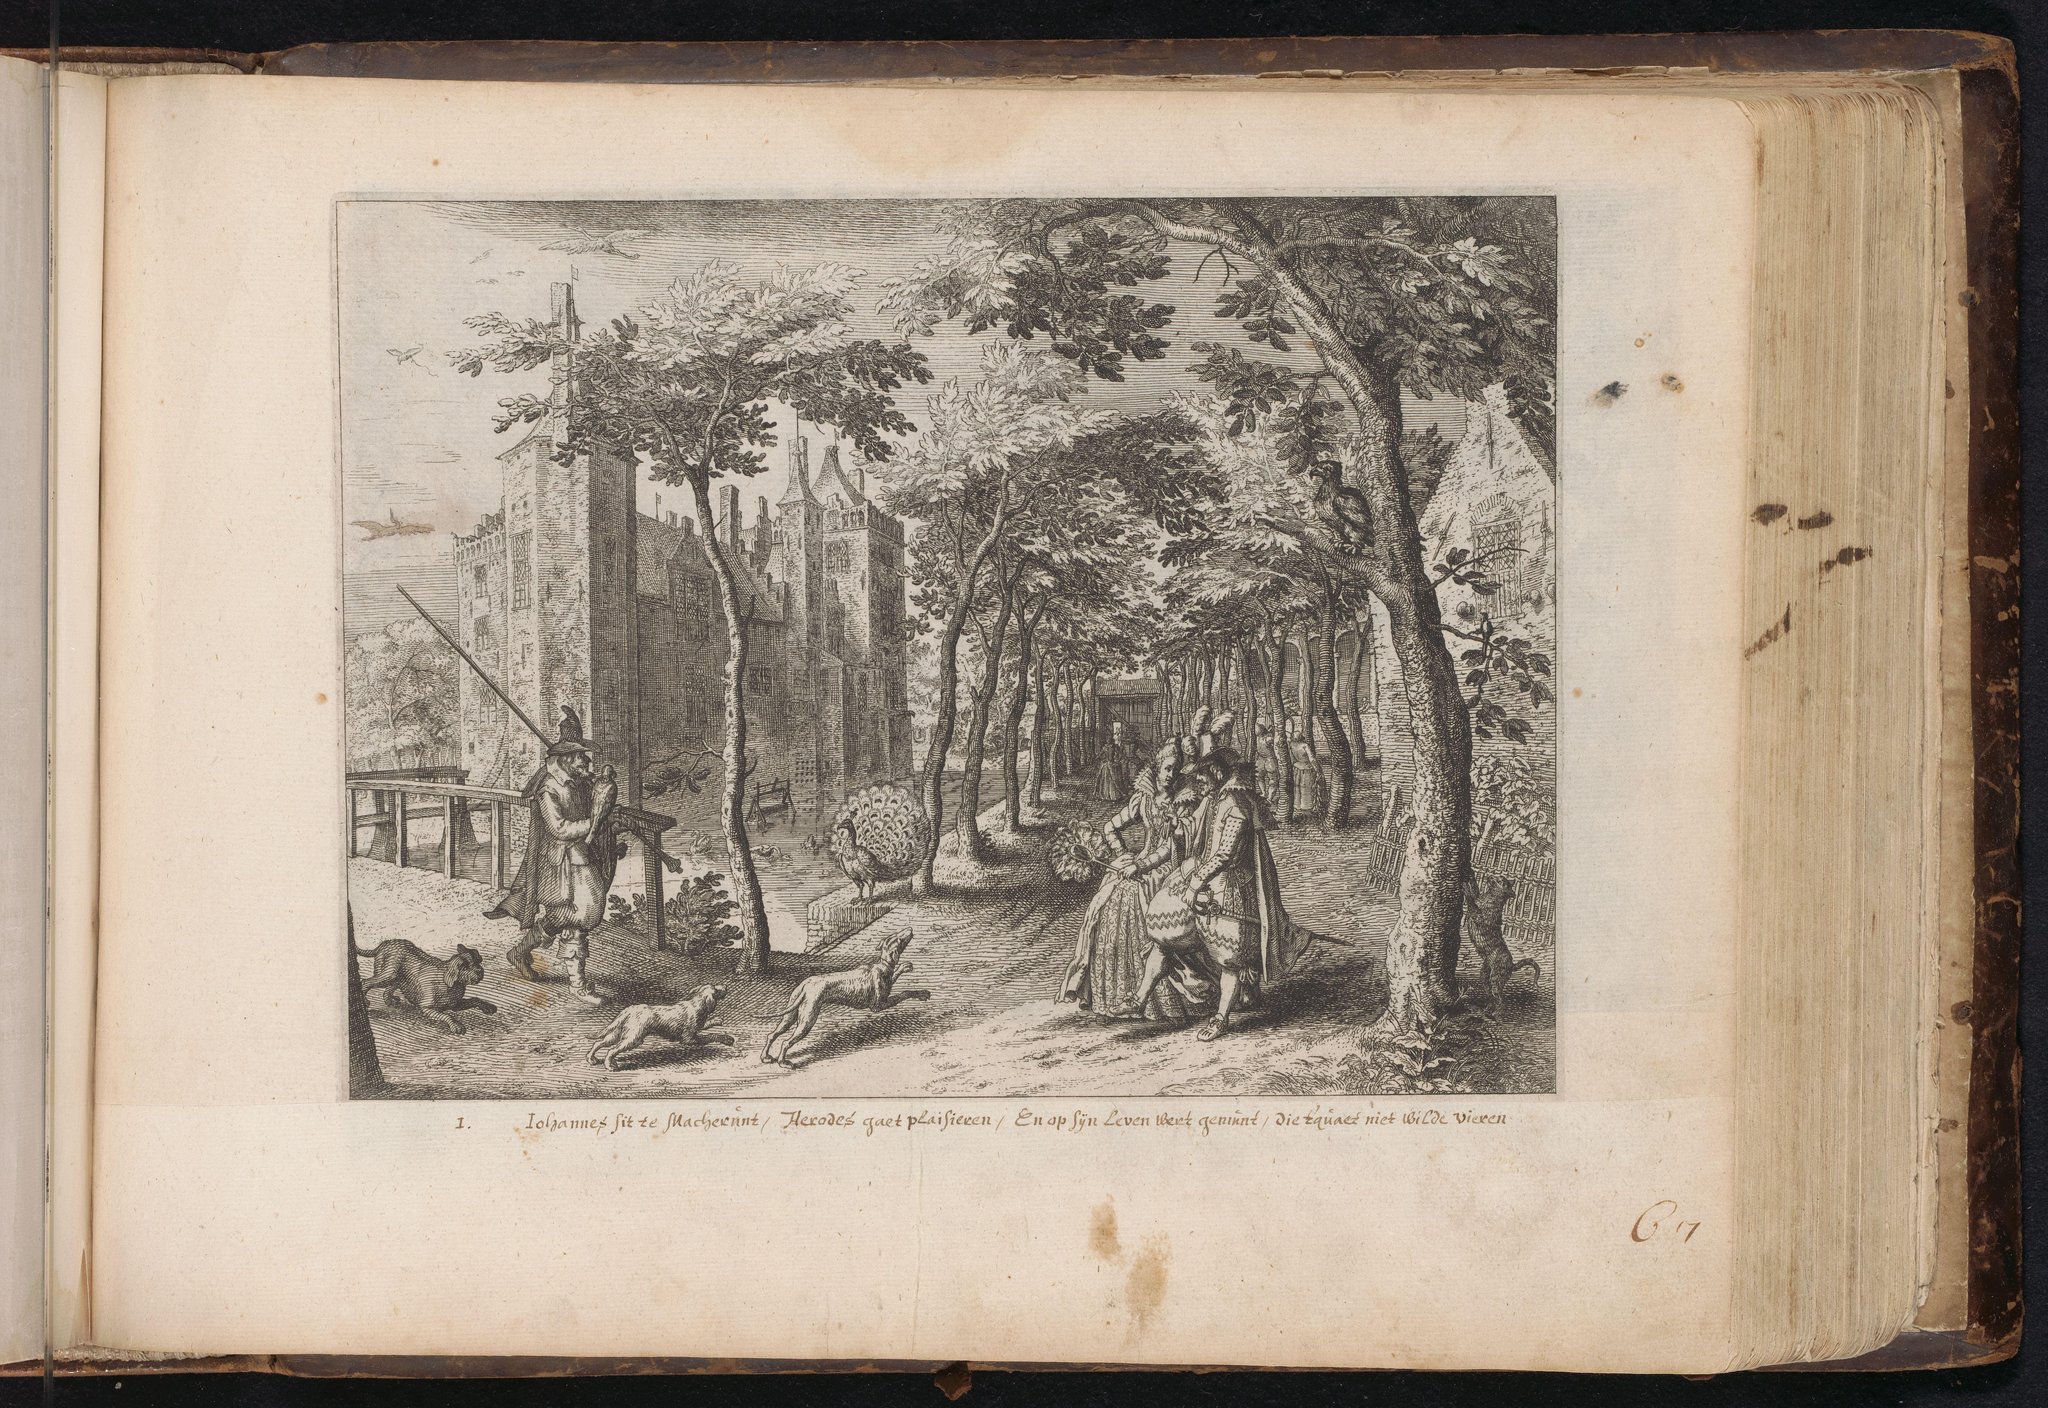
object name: print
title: Landschap met kasteel, jager en elegant paar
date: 1646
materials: paper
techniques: engraving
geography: alkmaar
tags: trees, castle, hunting dogs, hunter, fan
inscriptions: inscription: ‘1. Iohannes sit te Macherunt, Herodes gaet plaisieren, En op sijn Leven wert gemunt, die t' quaet niet wilde vieren’, number: ‘67’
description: Landschap met links een kasteel, een jager met jachthonden en rechts een elegant paar. Volgens het opschrift onder de voorstelling moet de voorstelling worden geïnterpreteerd als het hof van Herodes waar de dood van Johannes werd beraamd. Deze prent maakt deel uit van een album.